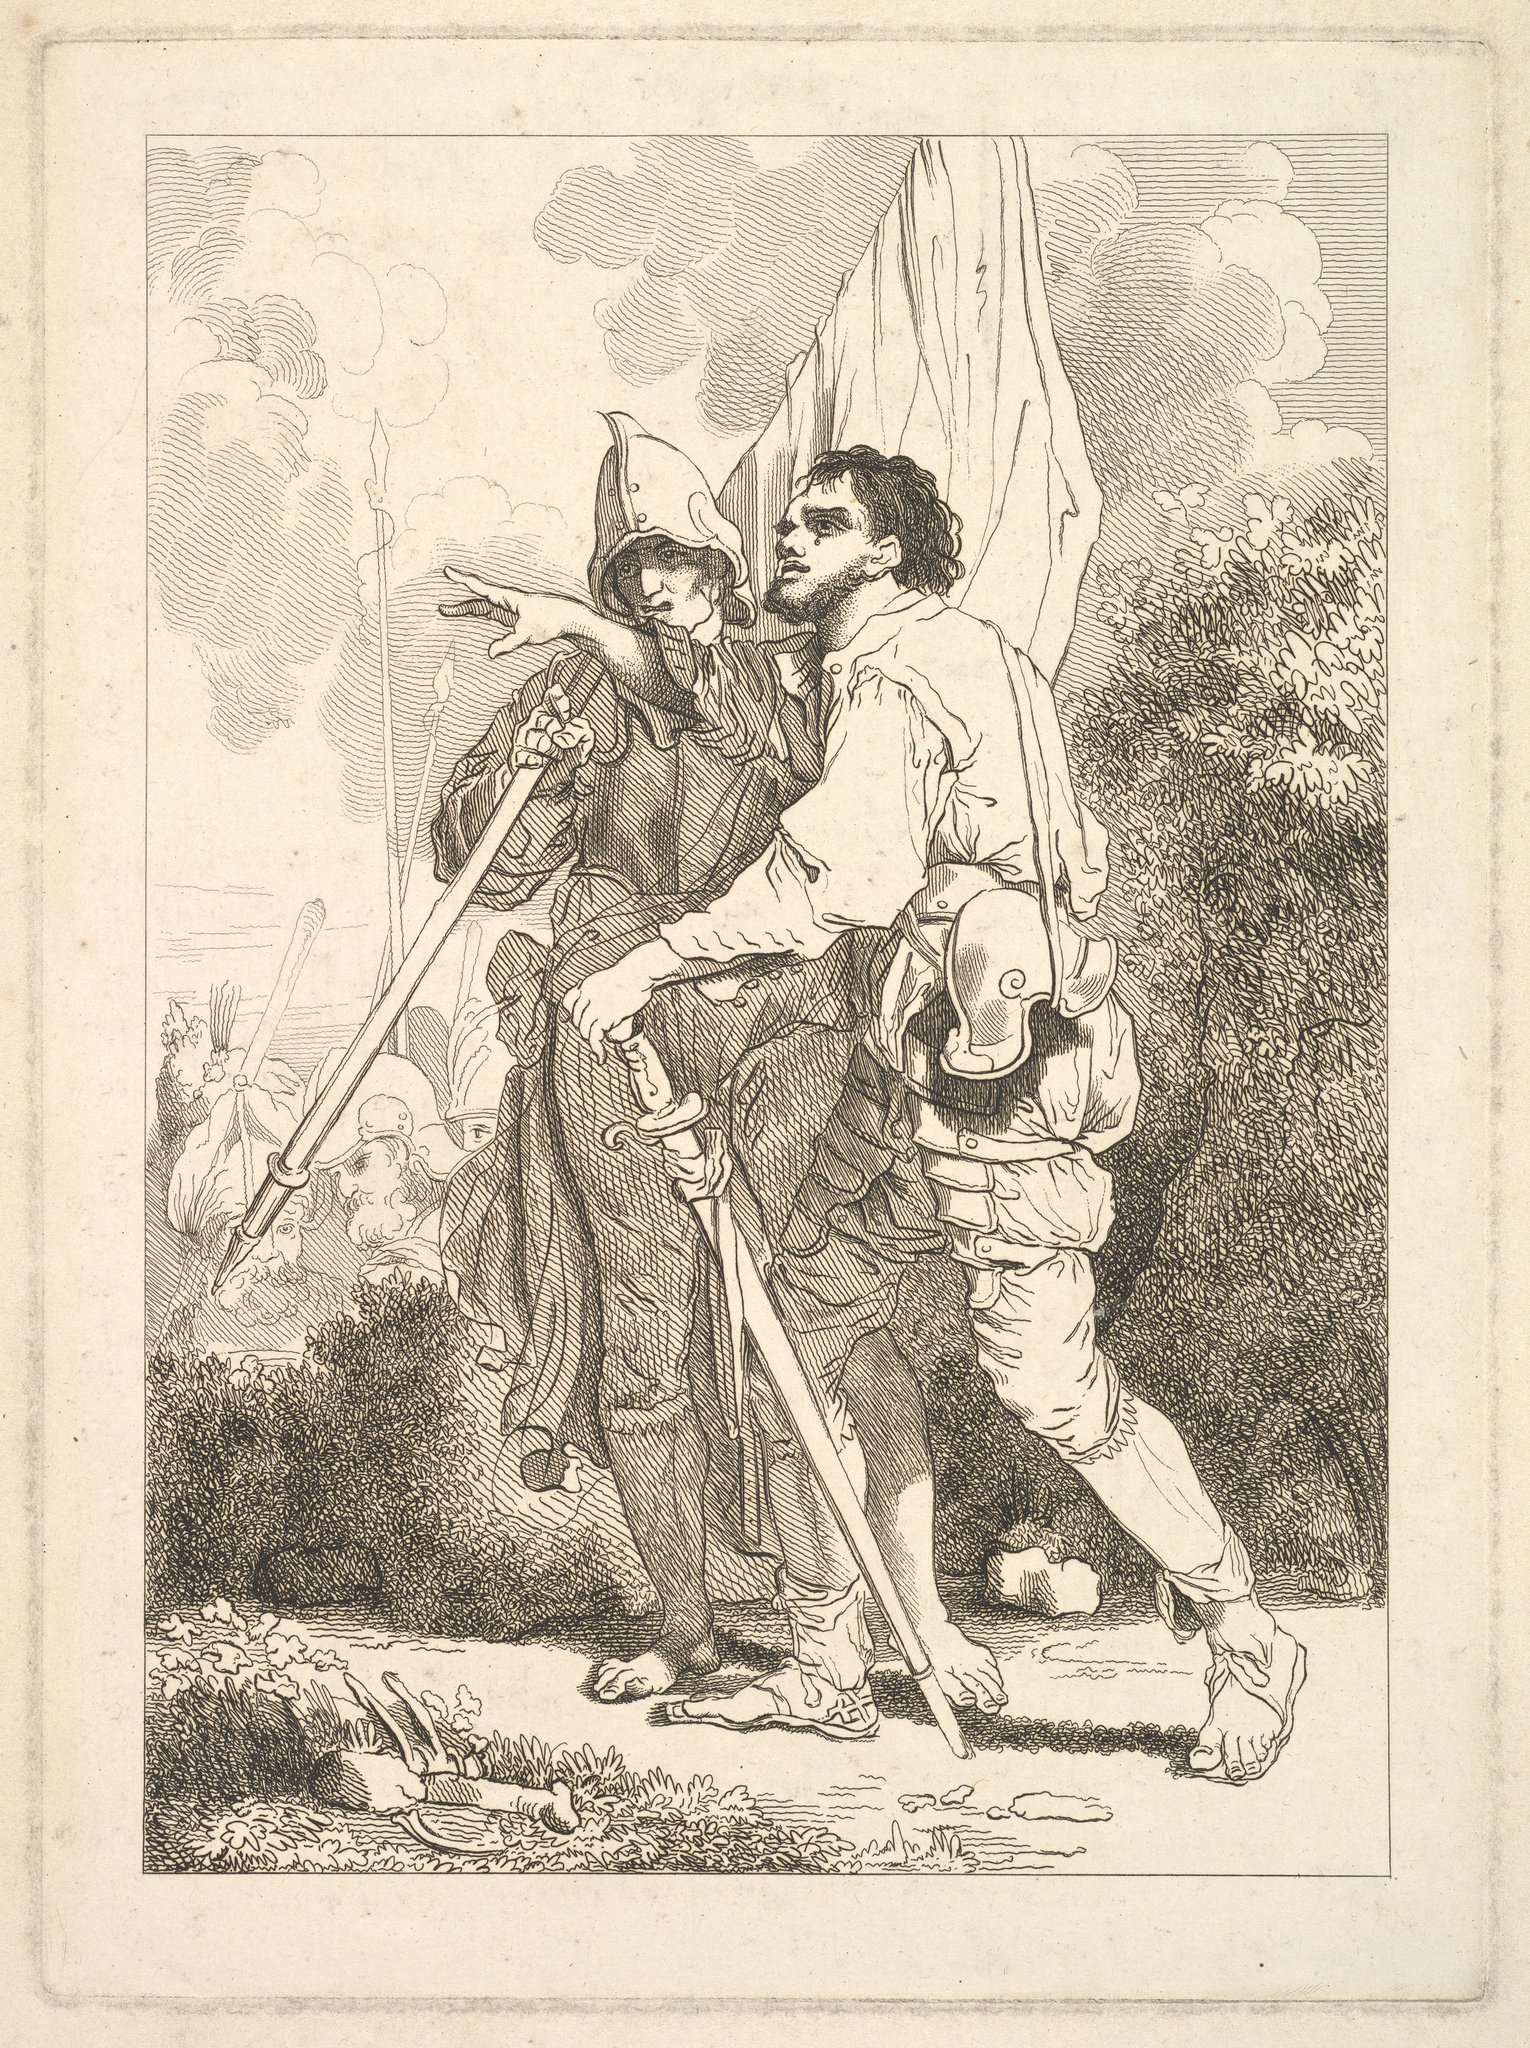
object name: print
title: Going Out in the Morning, from "Banditti Variously Employed"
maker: robert blyth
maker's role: artist and publisher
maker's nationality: british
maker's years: 1750-1784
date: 1779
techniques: etching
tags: swords,men,flags